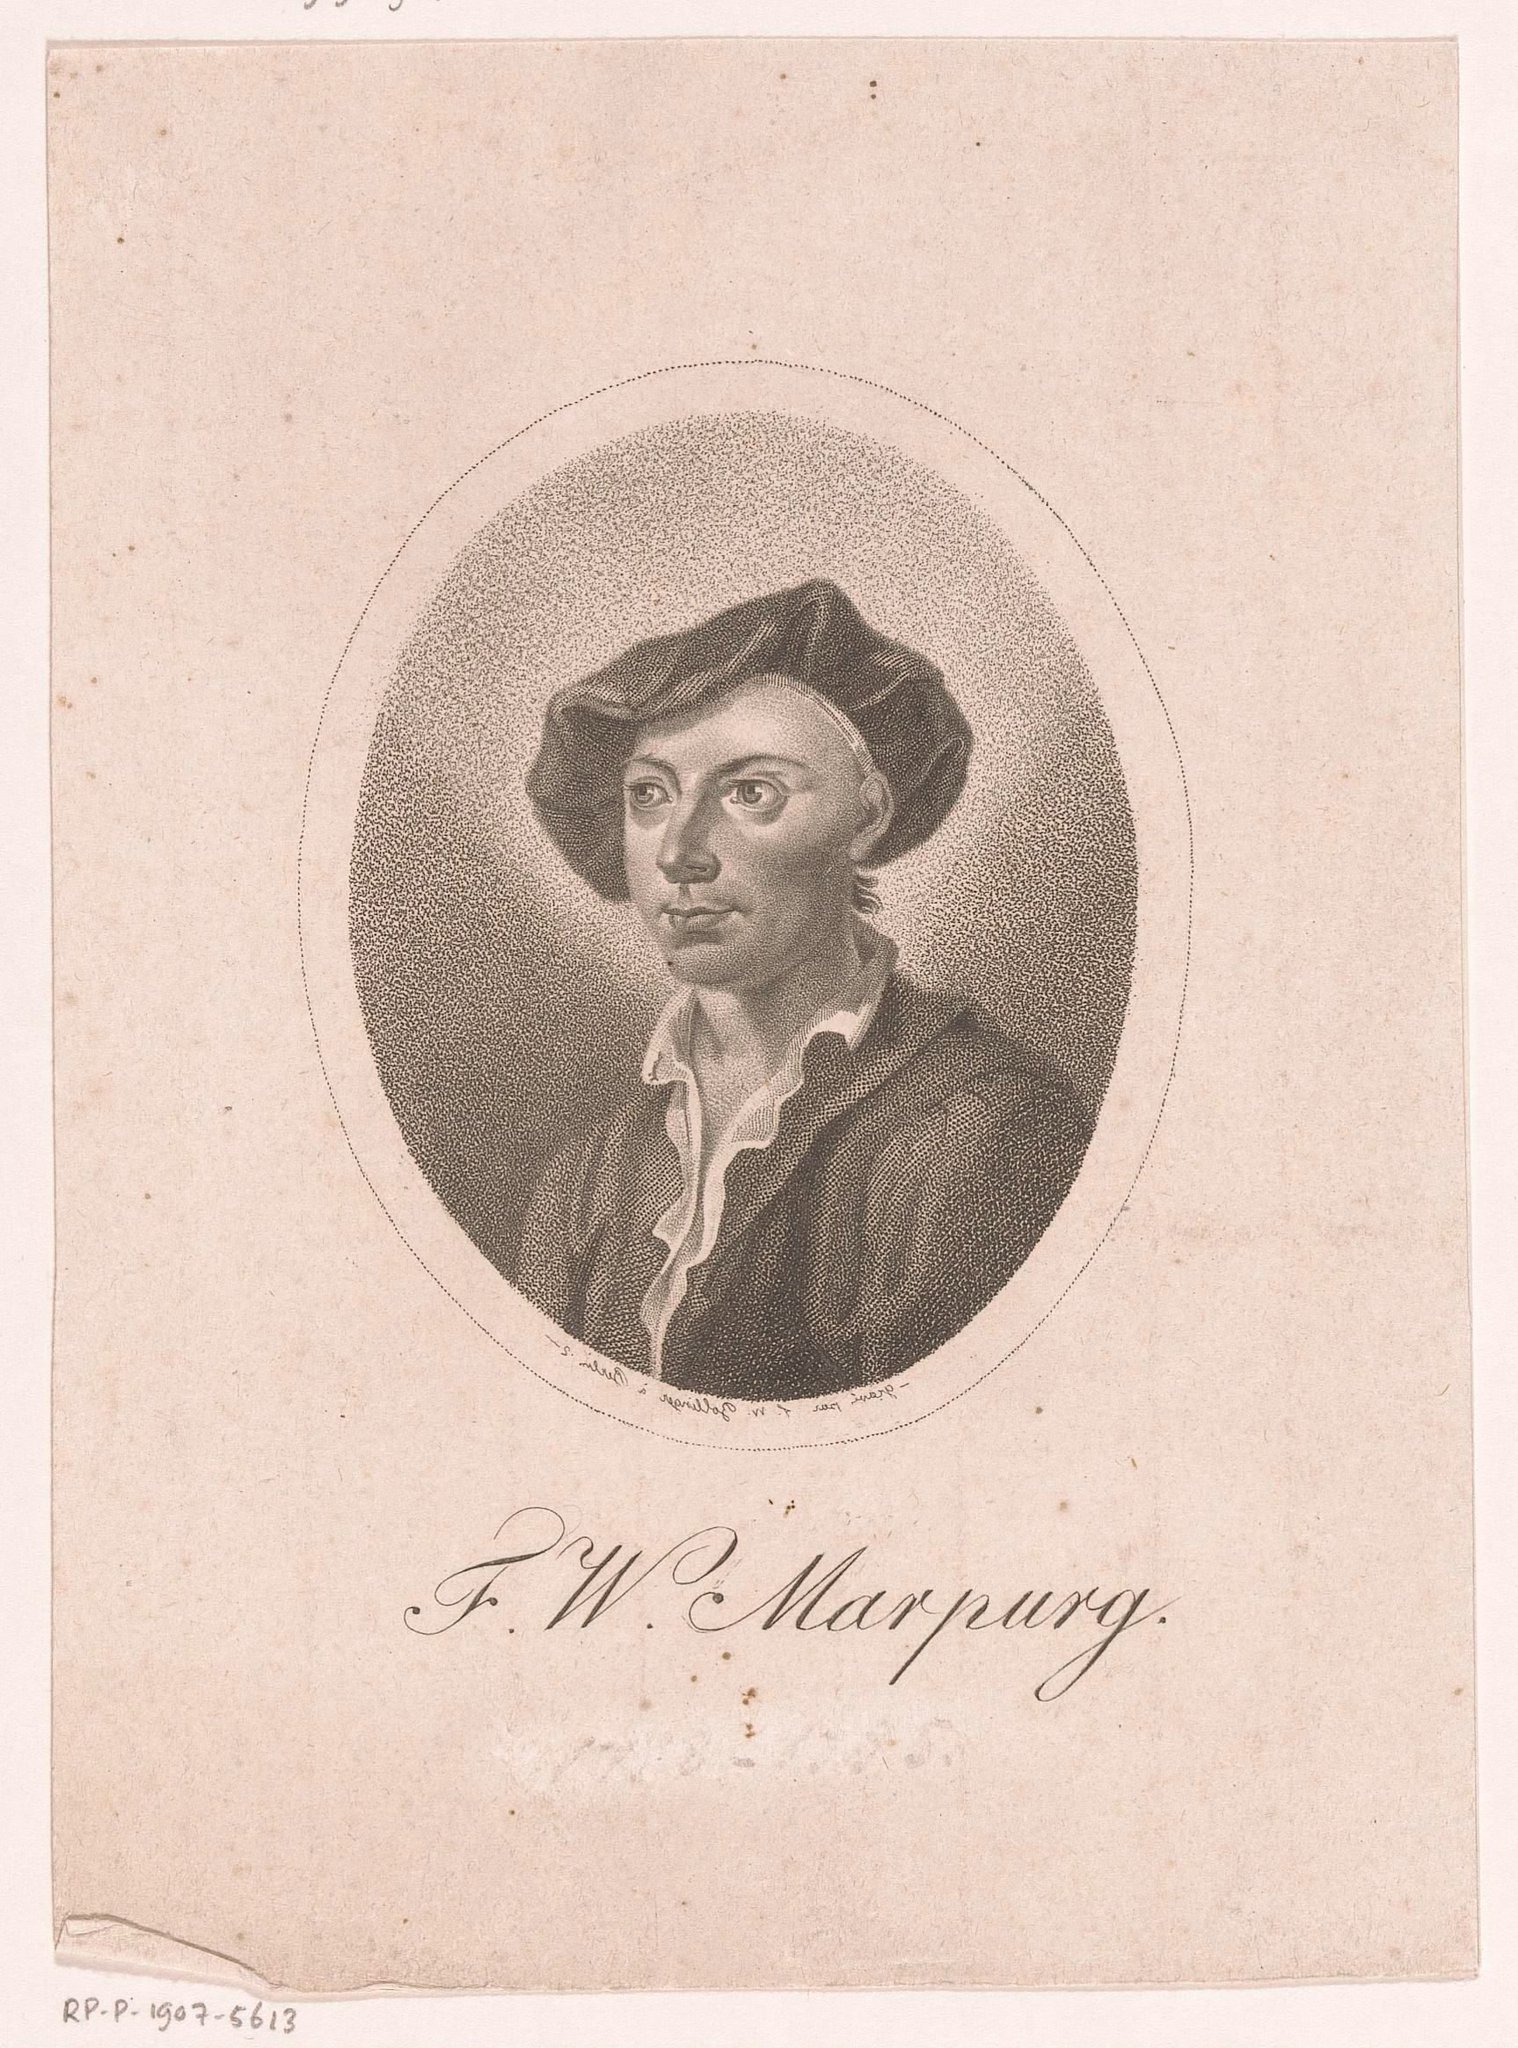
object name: print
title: Portret van Friedrich Wilhelm Marpurg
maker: friedrich wilhelm bollinger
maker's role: print maker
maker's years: 1777-1825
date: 1787-1825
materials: paper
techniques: stippling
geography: berlin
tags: historical persons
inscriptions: collector's mark: Lugt 2228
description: Onder het portret de naam van de kunstenaar en mogelijk ook een datering ('2') in spiegelbeeld.